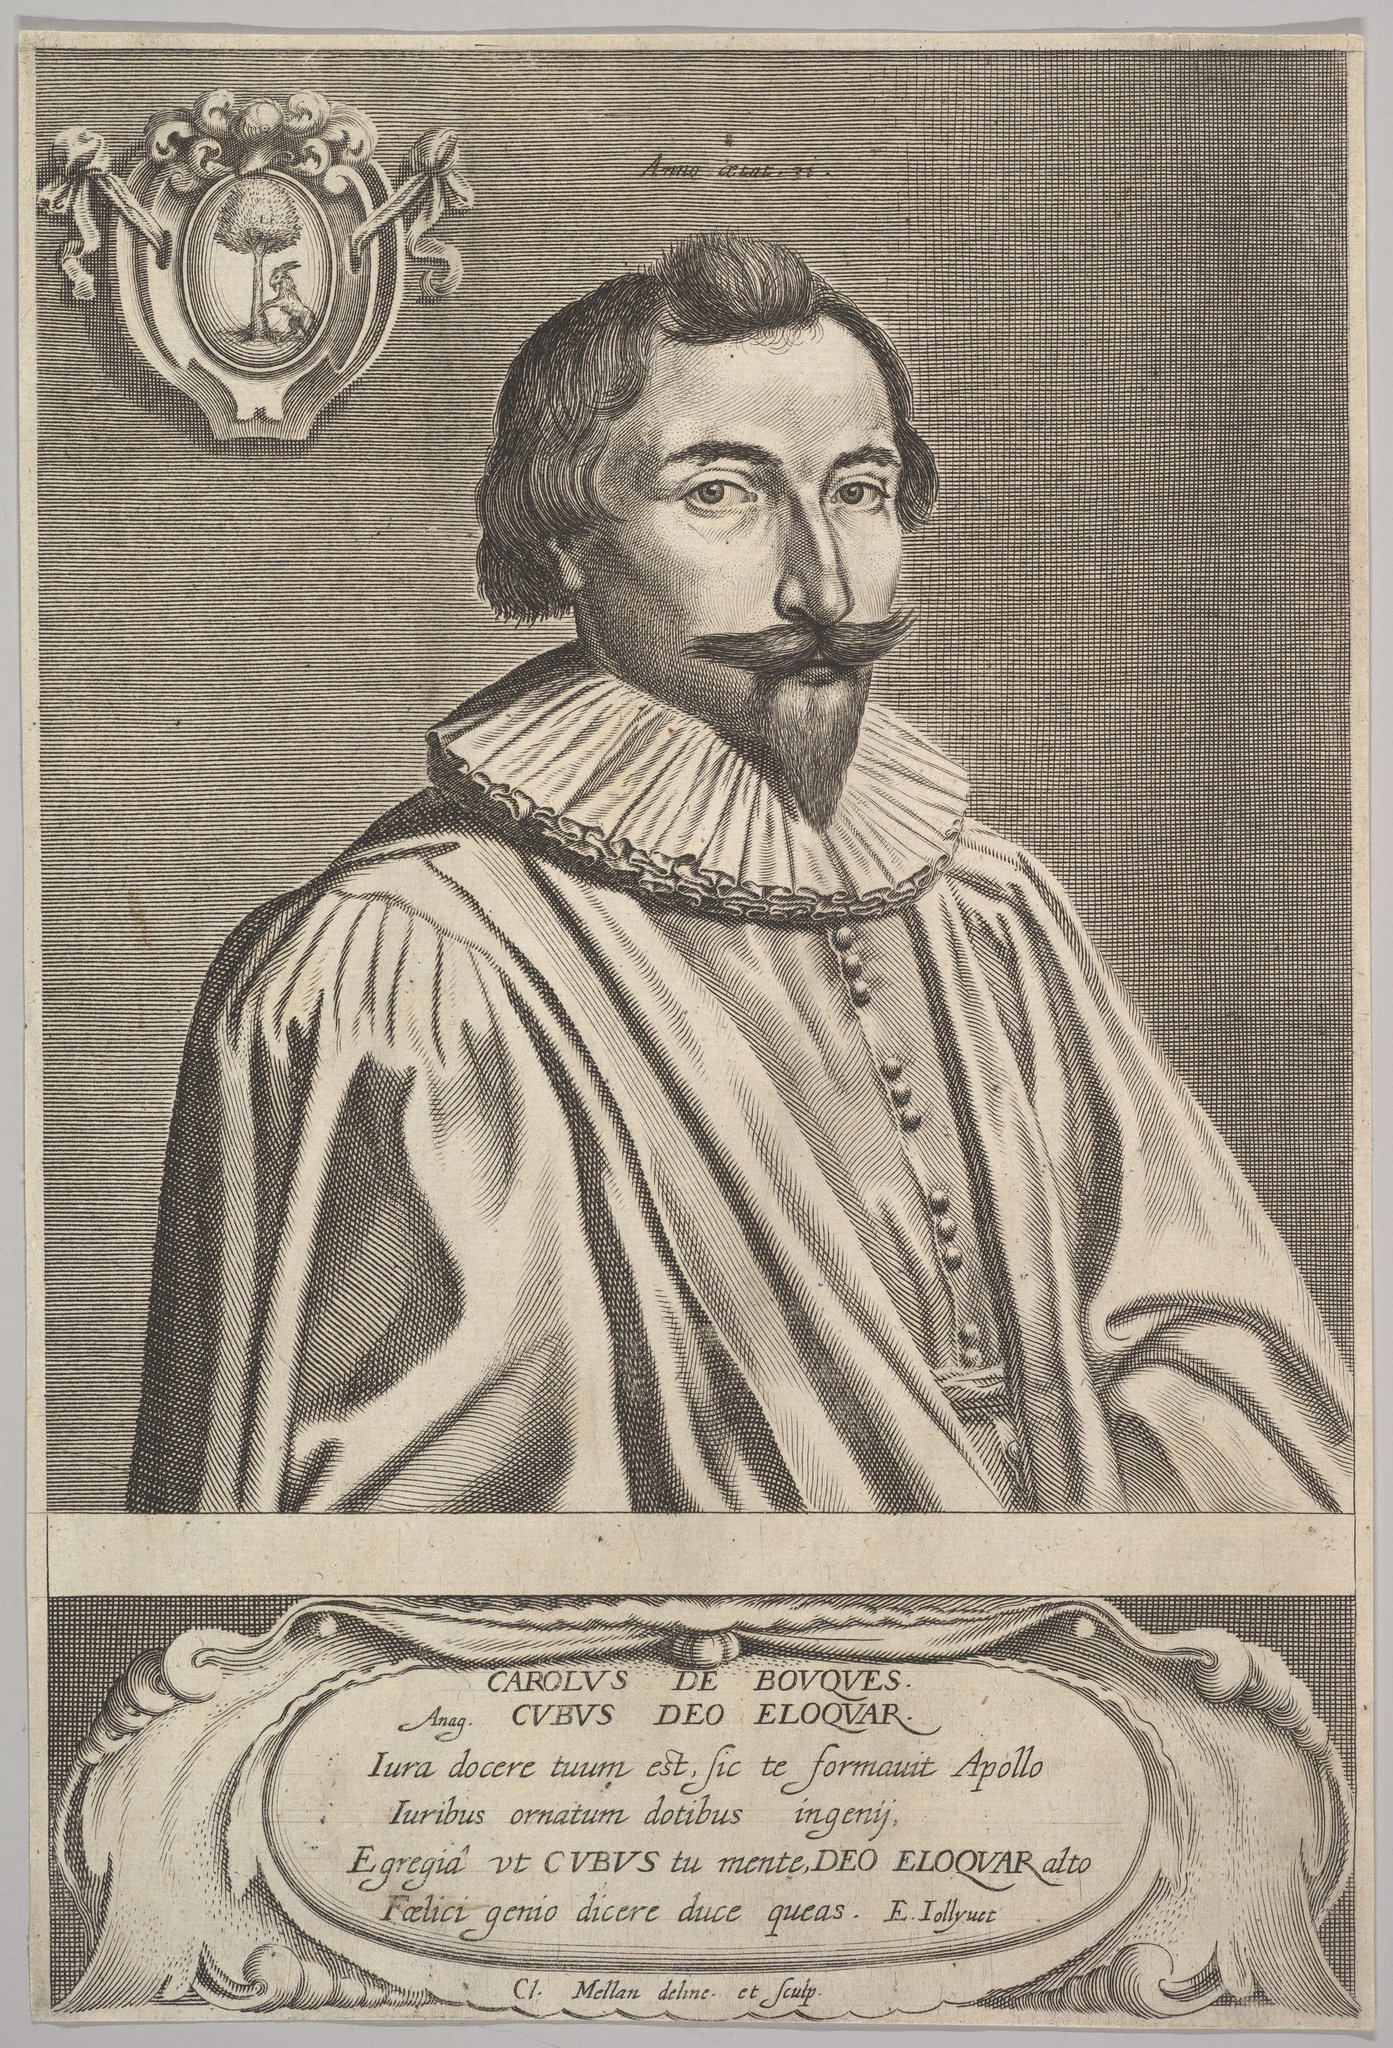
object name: print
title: Charles de Bouques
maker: claude mellan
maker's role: artist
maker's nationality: french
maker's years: 1598-1688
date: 1600-1688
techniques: engraving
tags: men,portraits